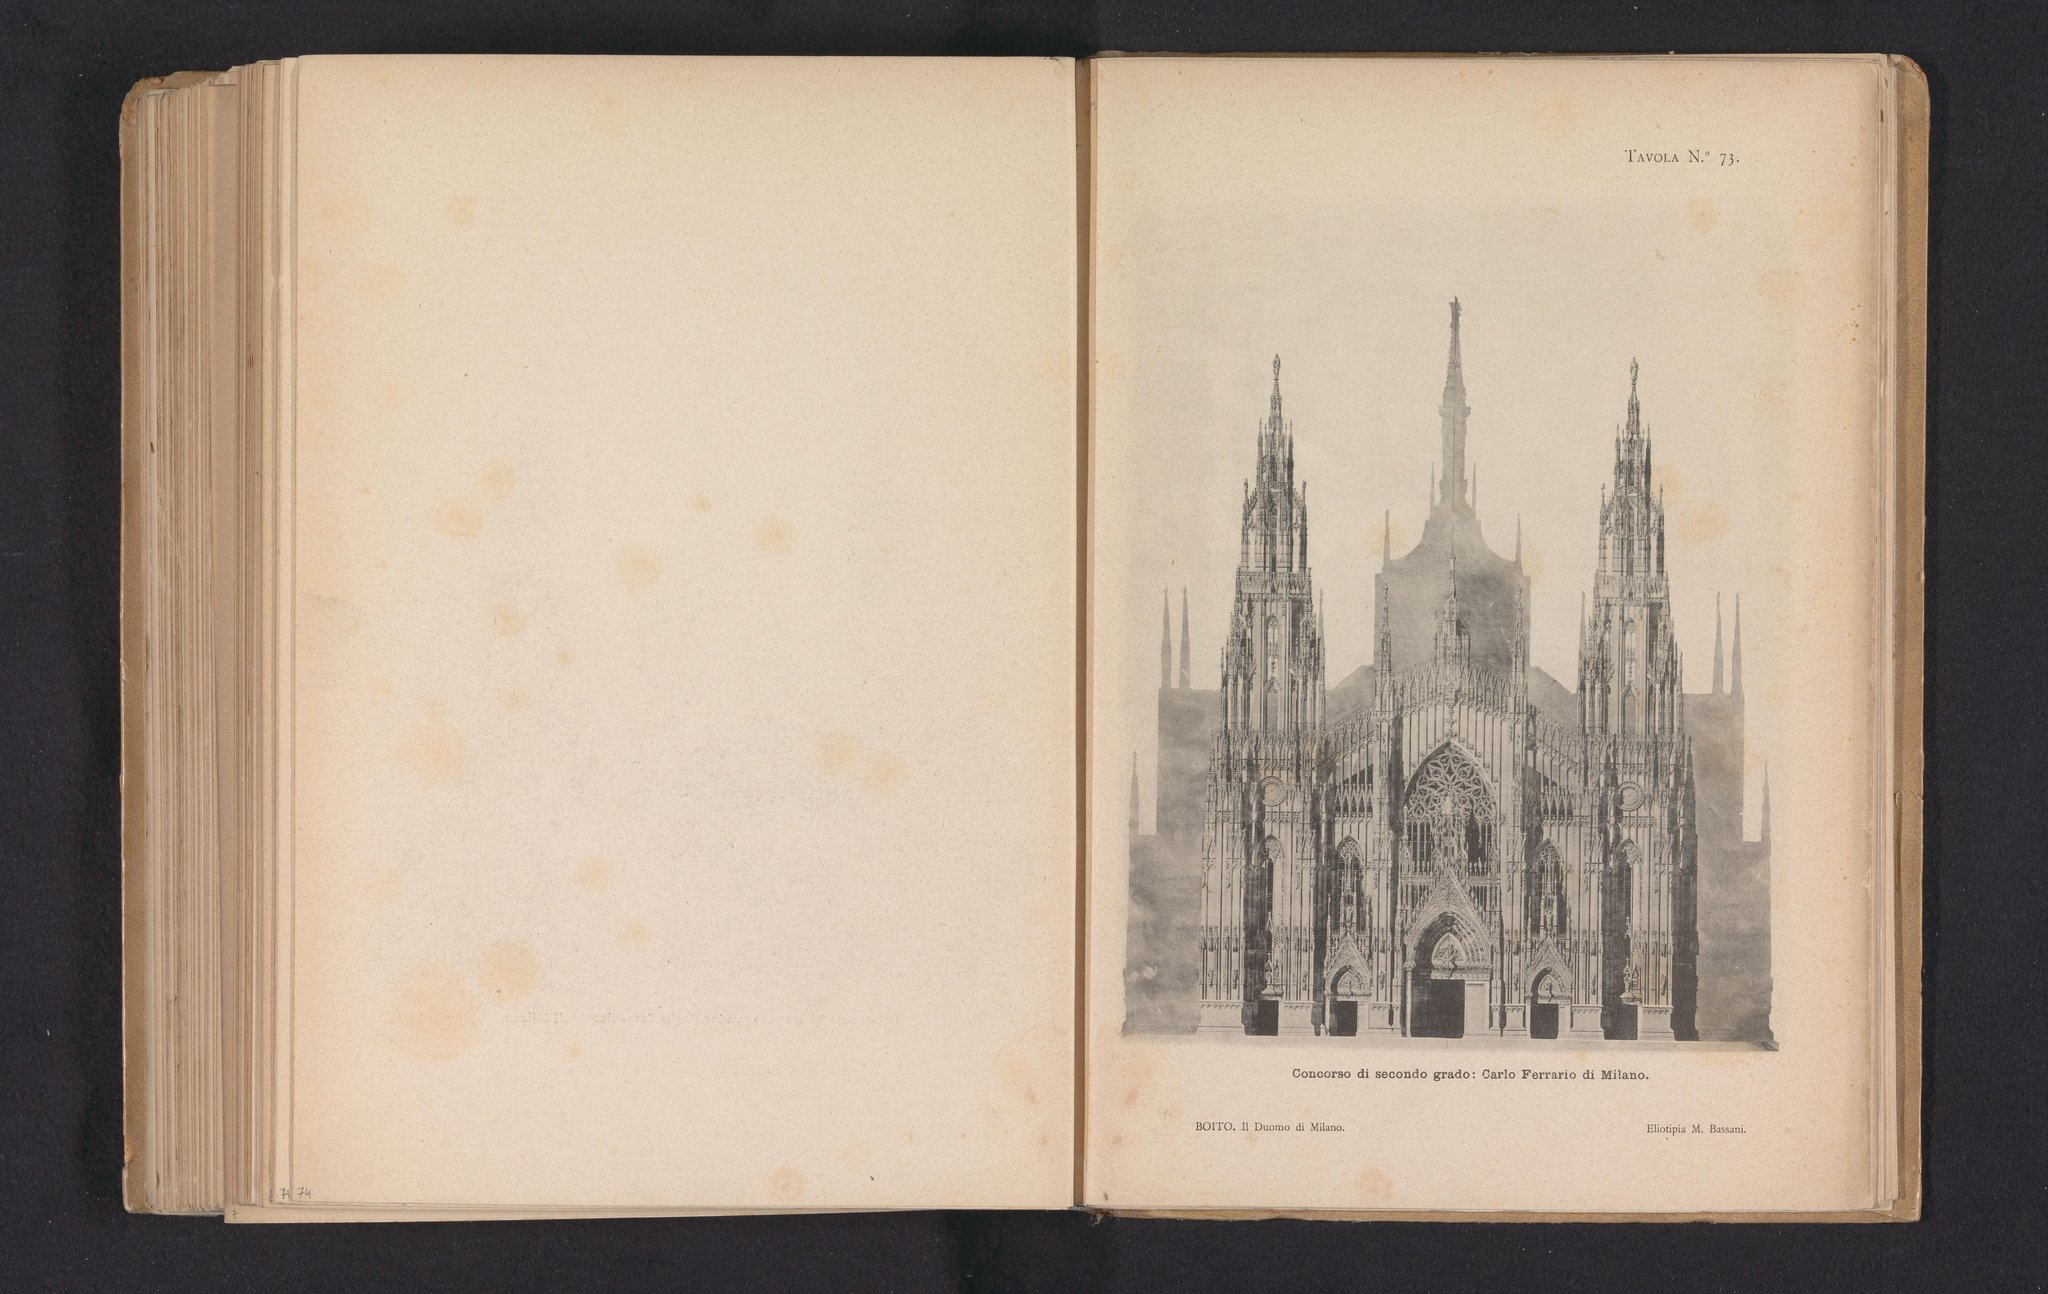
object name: page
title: Concorso di secondo grado : Carlo Ferrario di Milano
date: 1886-1889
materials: paper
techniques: photograph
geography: milan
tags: drawing, sketch, parts of church exterior and annexes: façade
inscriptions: number: ‘Tavola No. 73.’